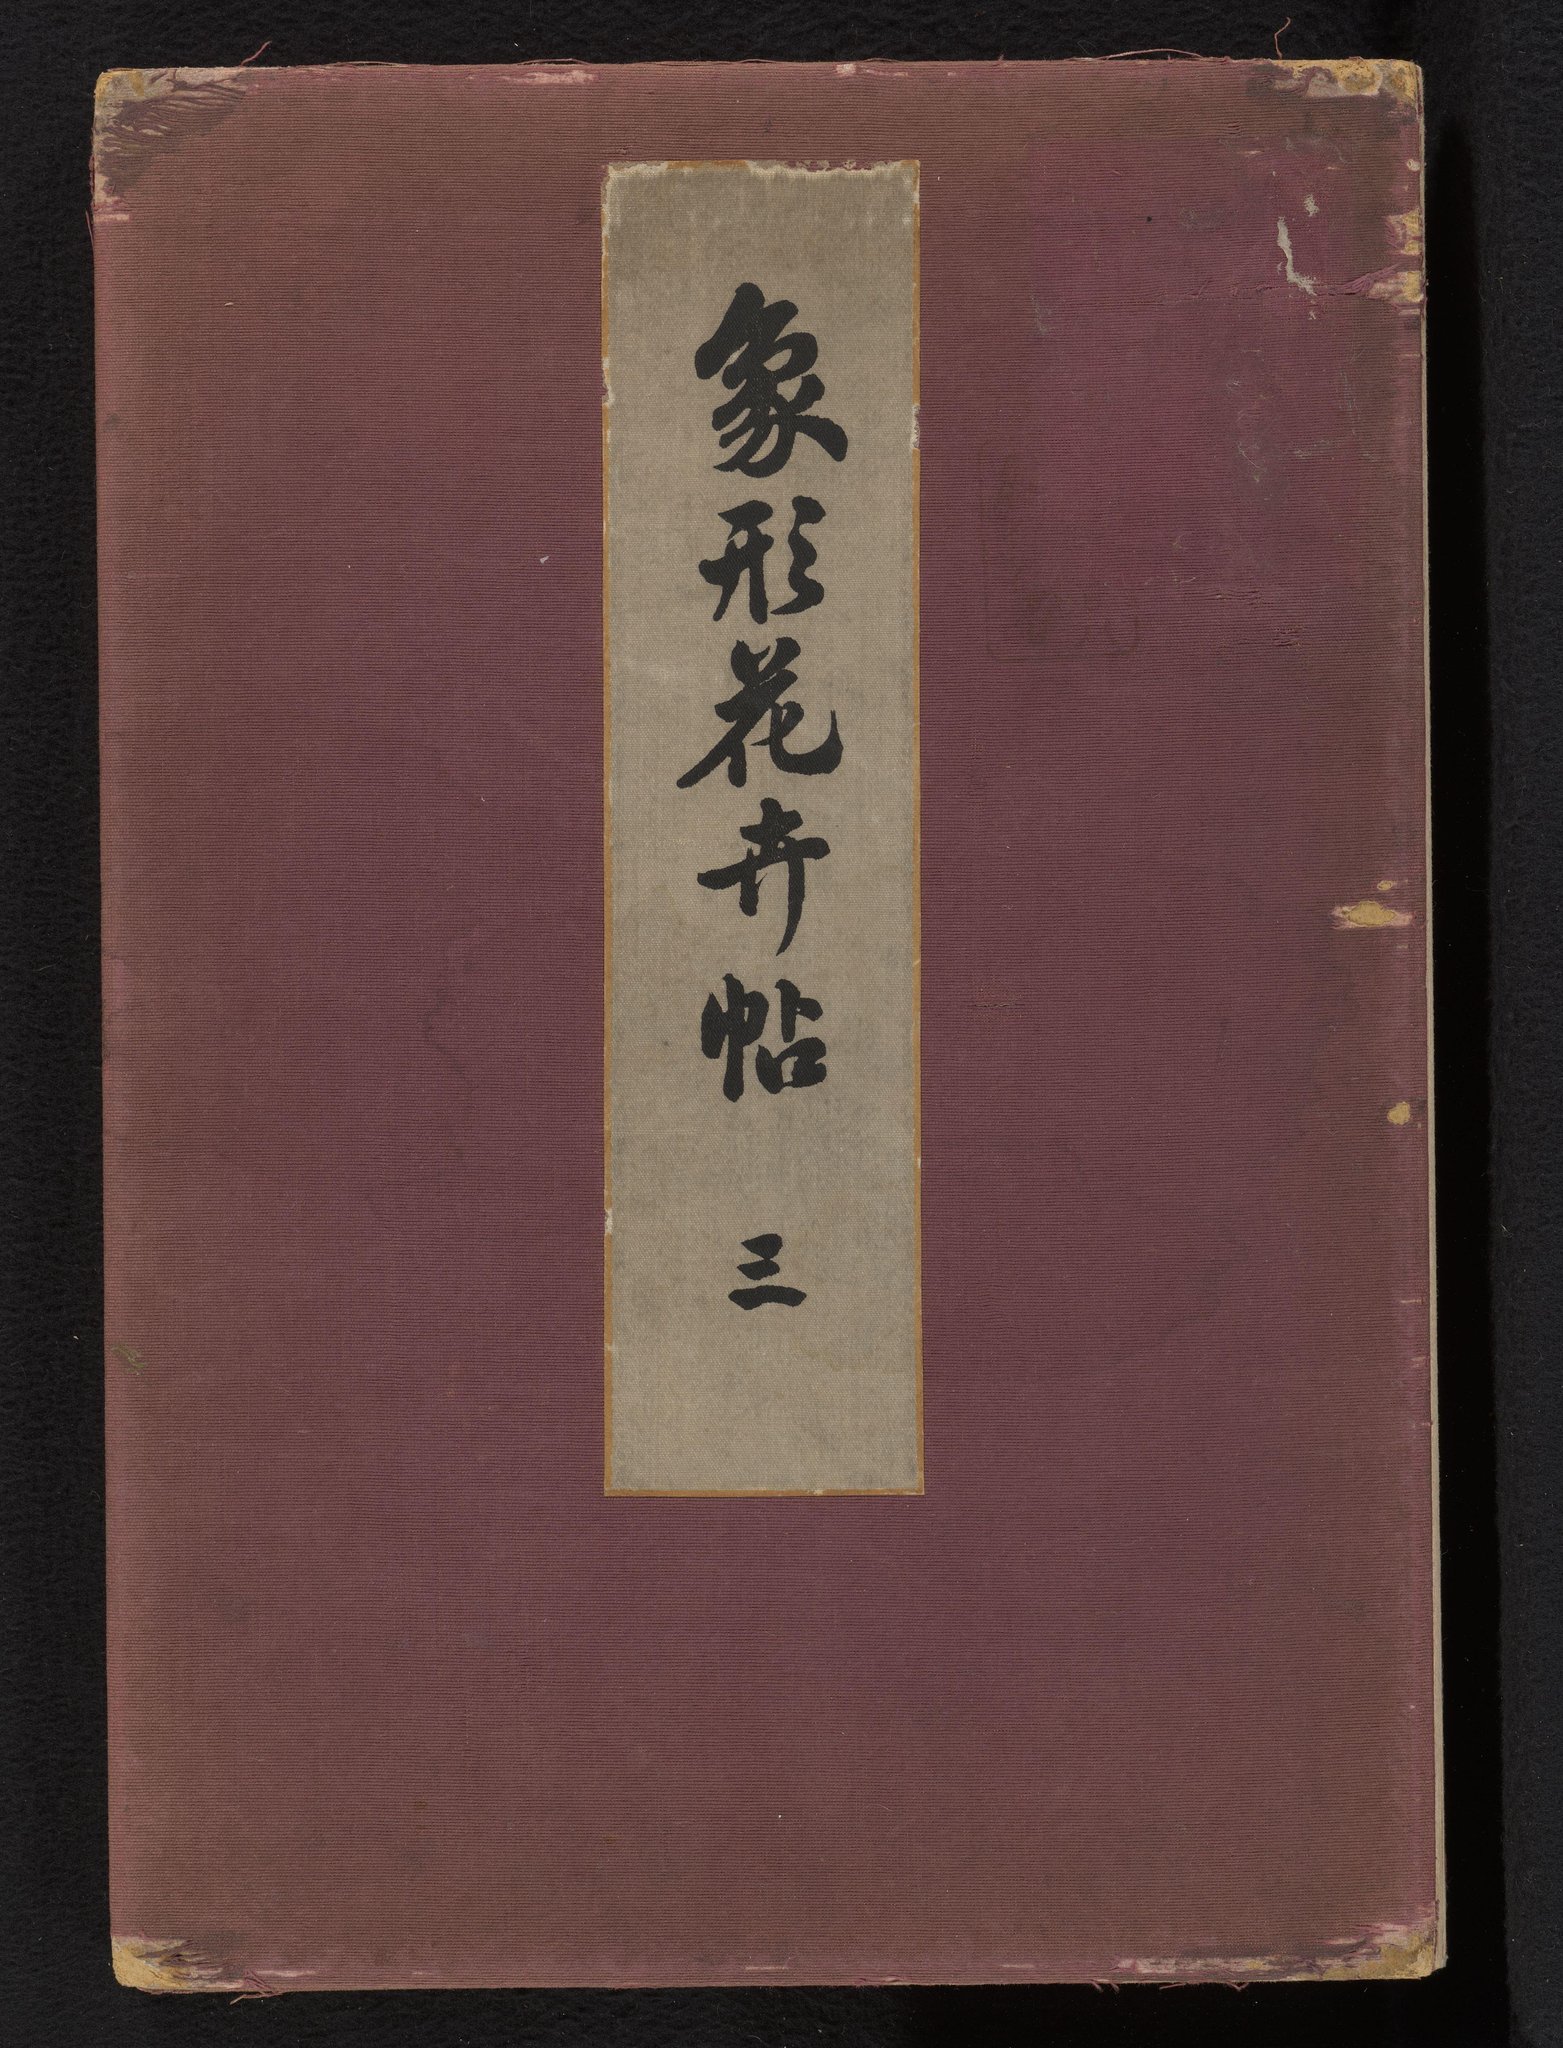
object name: prentrecueil, prentenalbum, prentalbum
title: Zokei kaben cho - san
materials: paper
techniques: blind stamped, woodcut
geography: kyoto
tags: flowers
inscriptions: date